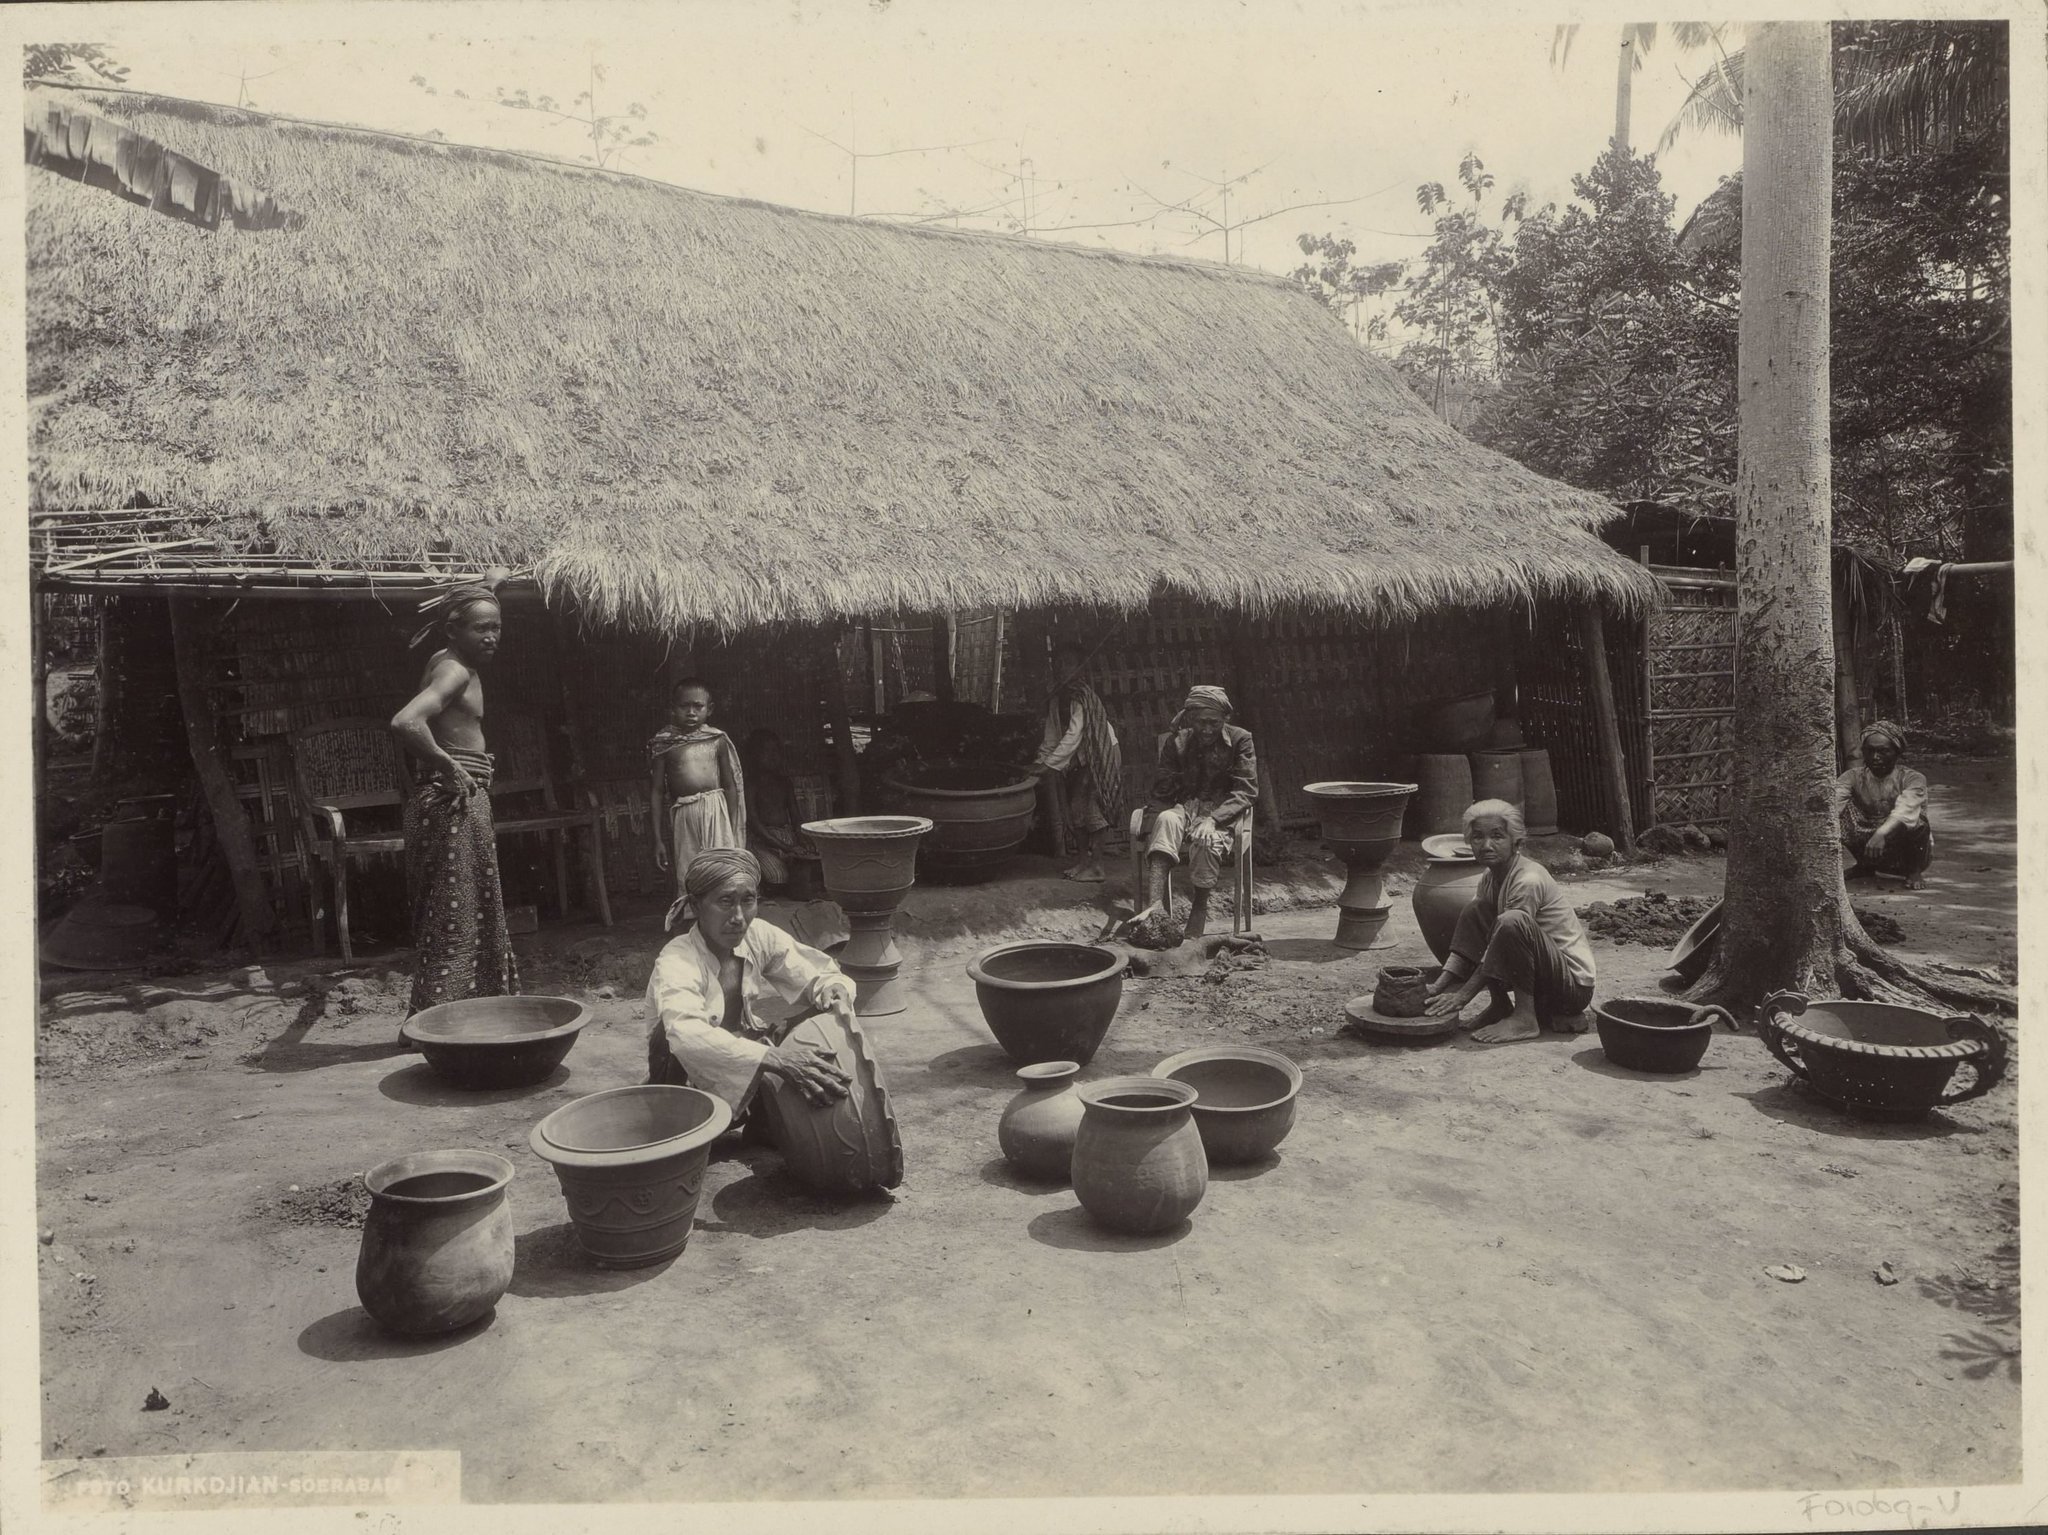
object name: photograph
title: Pottenbakkers op een erf, mogelijk in Surabaya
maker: onnes kurkdjian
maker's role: fotograaf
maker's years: 1851-1903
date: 1912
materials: paper, photographic support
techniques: gelatin silver print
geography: surabaya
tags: potter, ceramist, surabaya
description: Onderdeel van Reisalbum met veertig foto's van Nederlands-Indië.